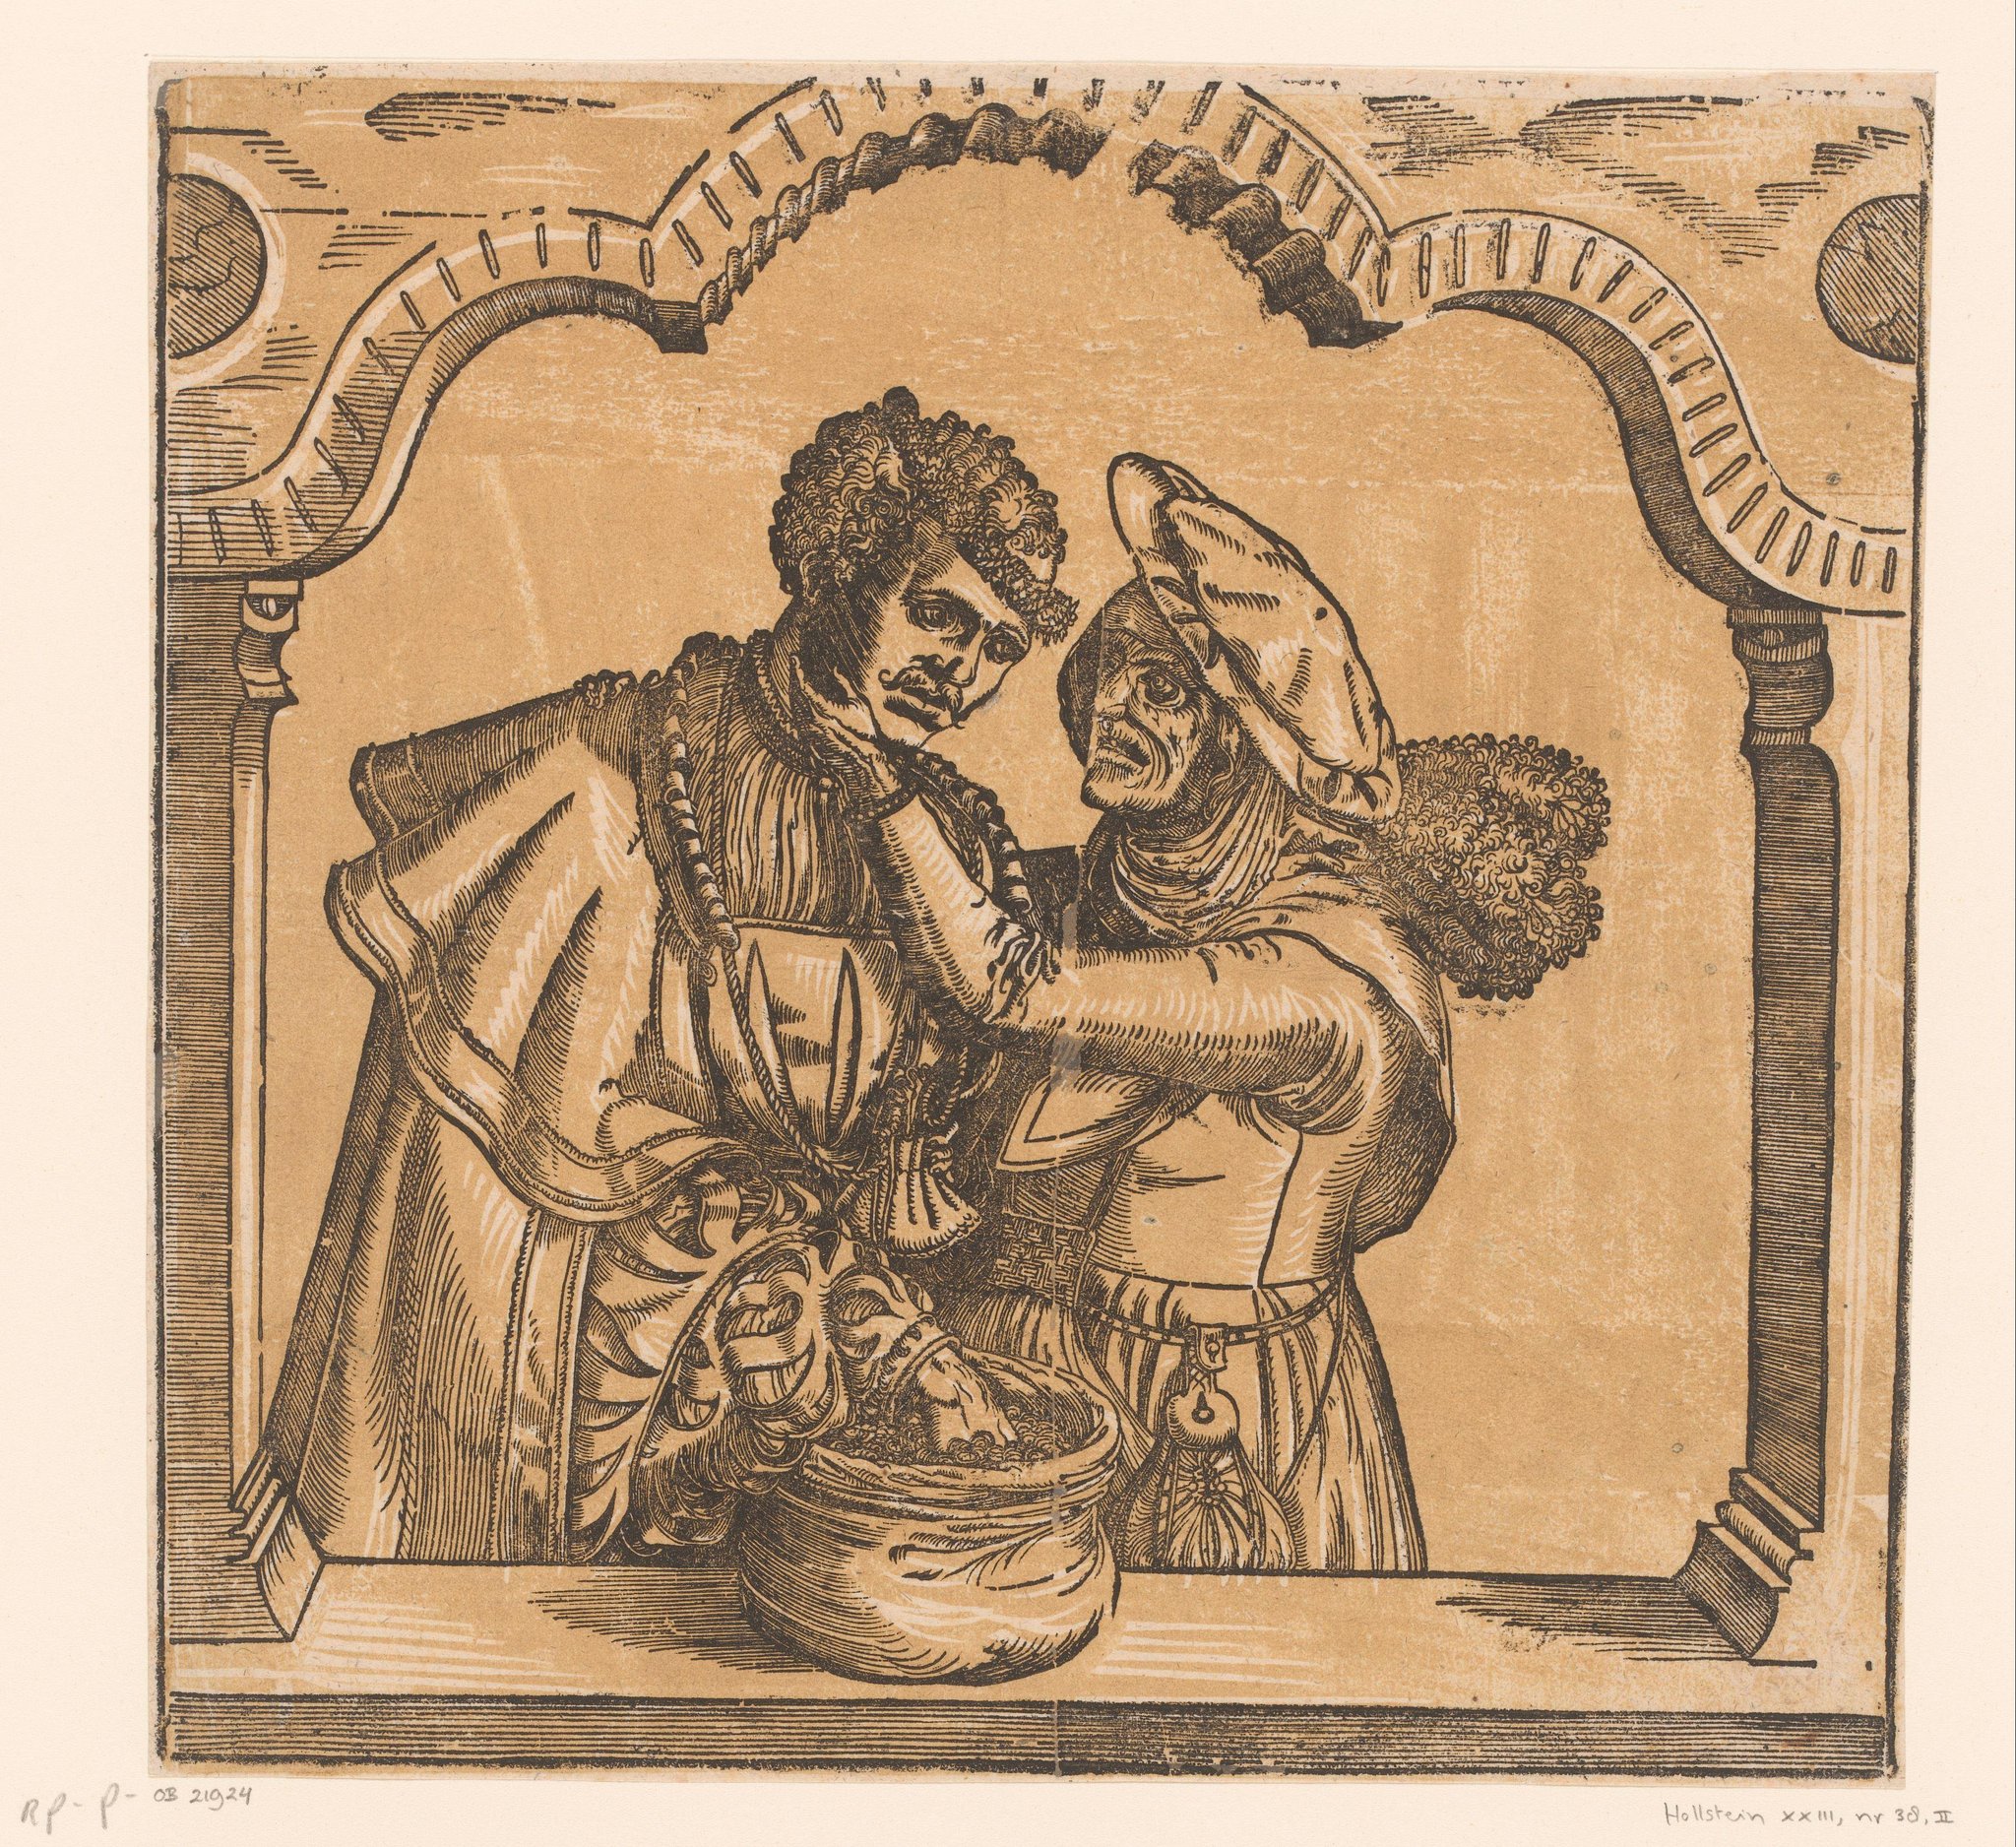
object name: print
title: Ongelijk paar: een jonge man met een oude vrouw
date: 1506-1568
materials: paper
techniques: woodcut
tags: married couple of unequal age - dd - woman older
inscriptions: collector's mark: Lugt 240